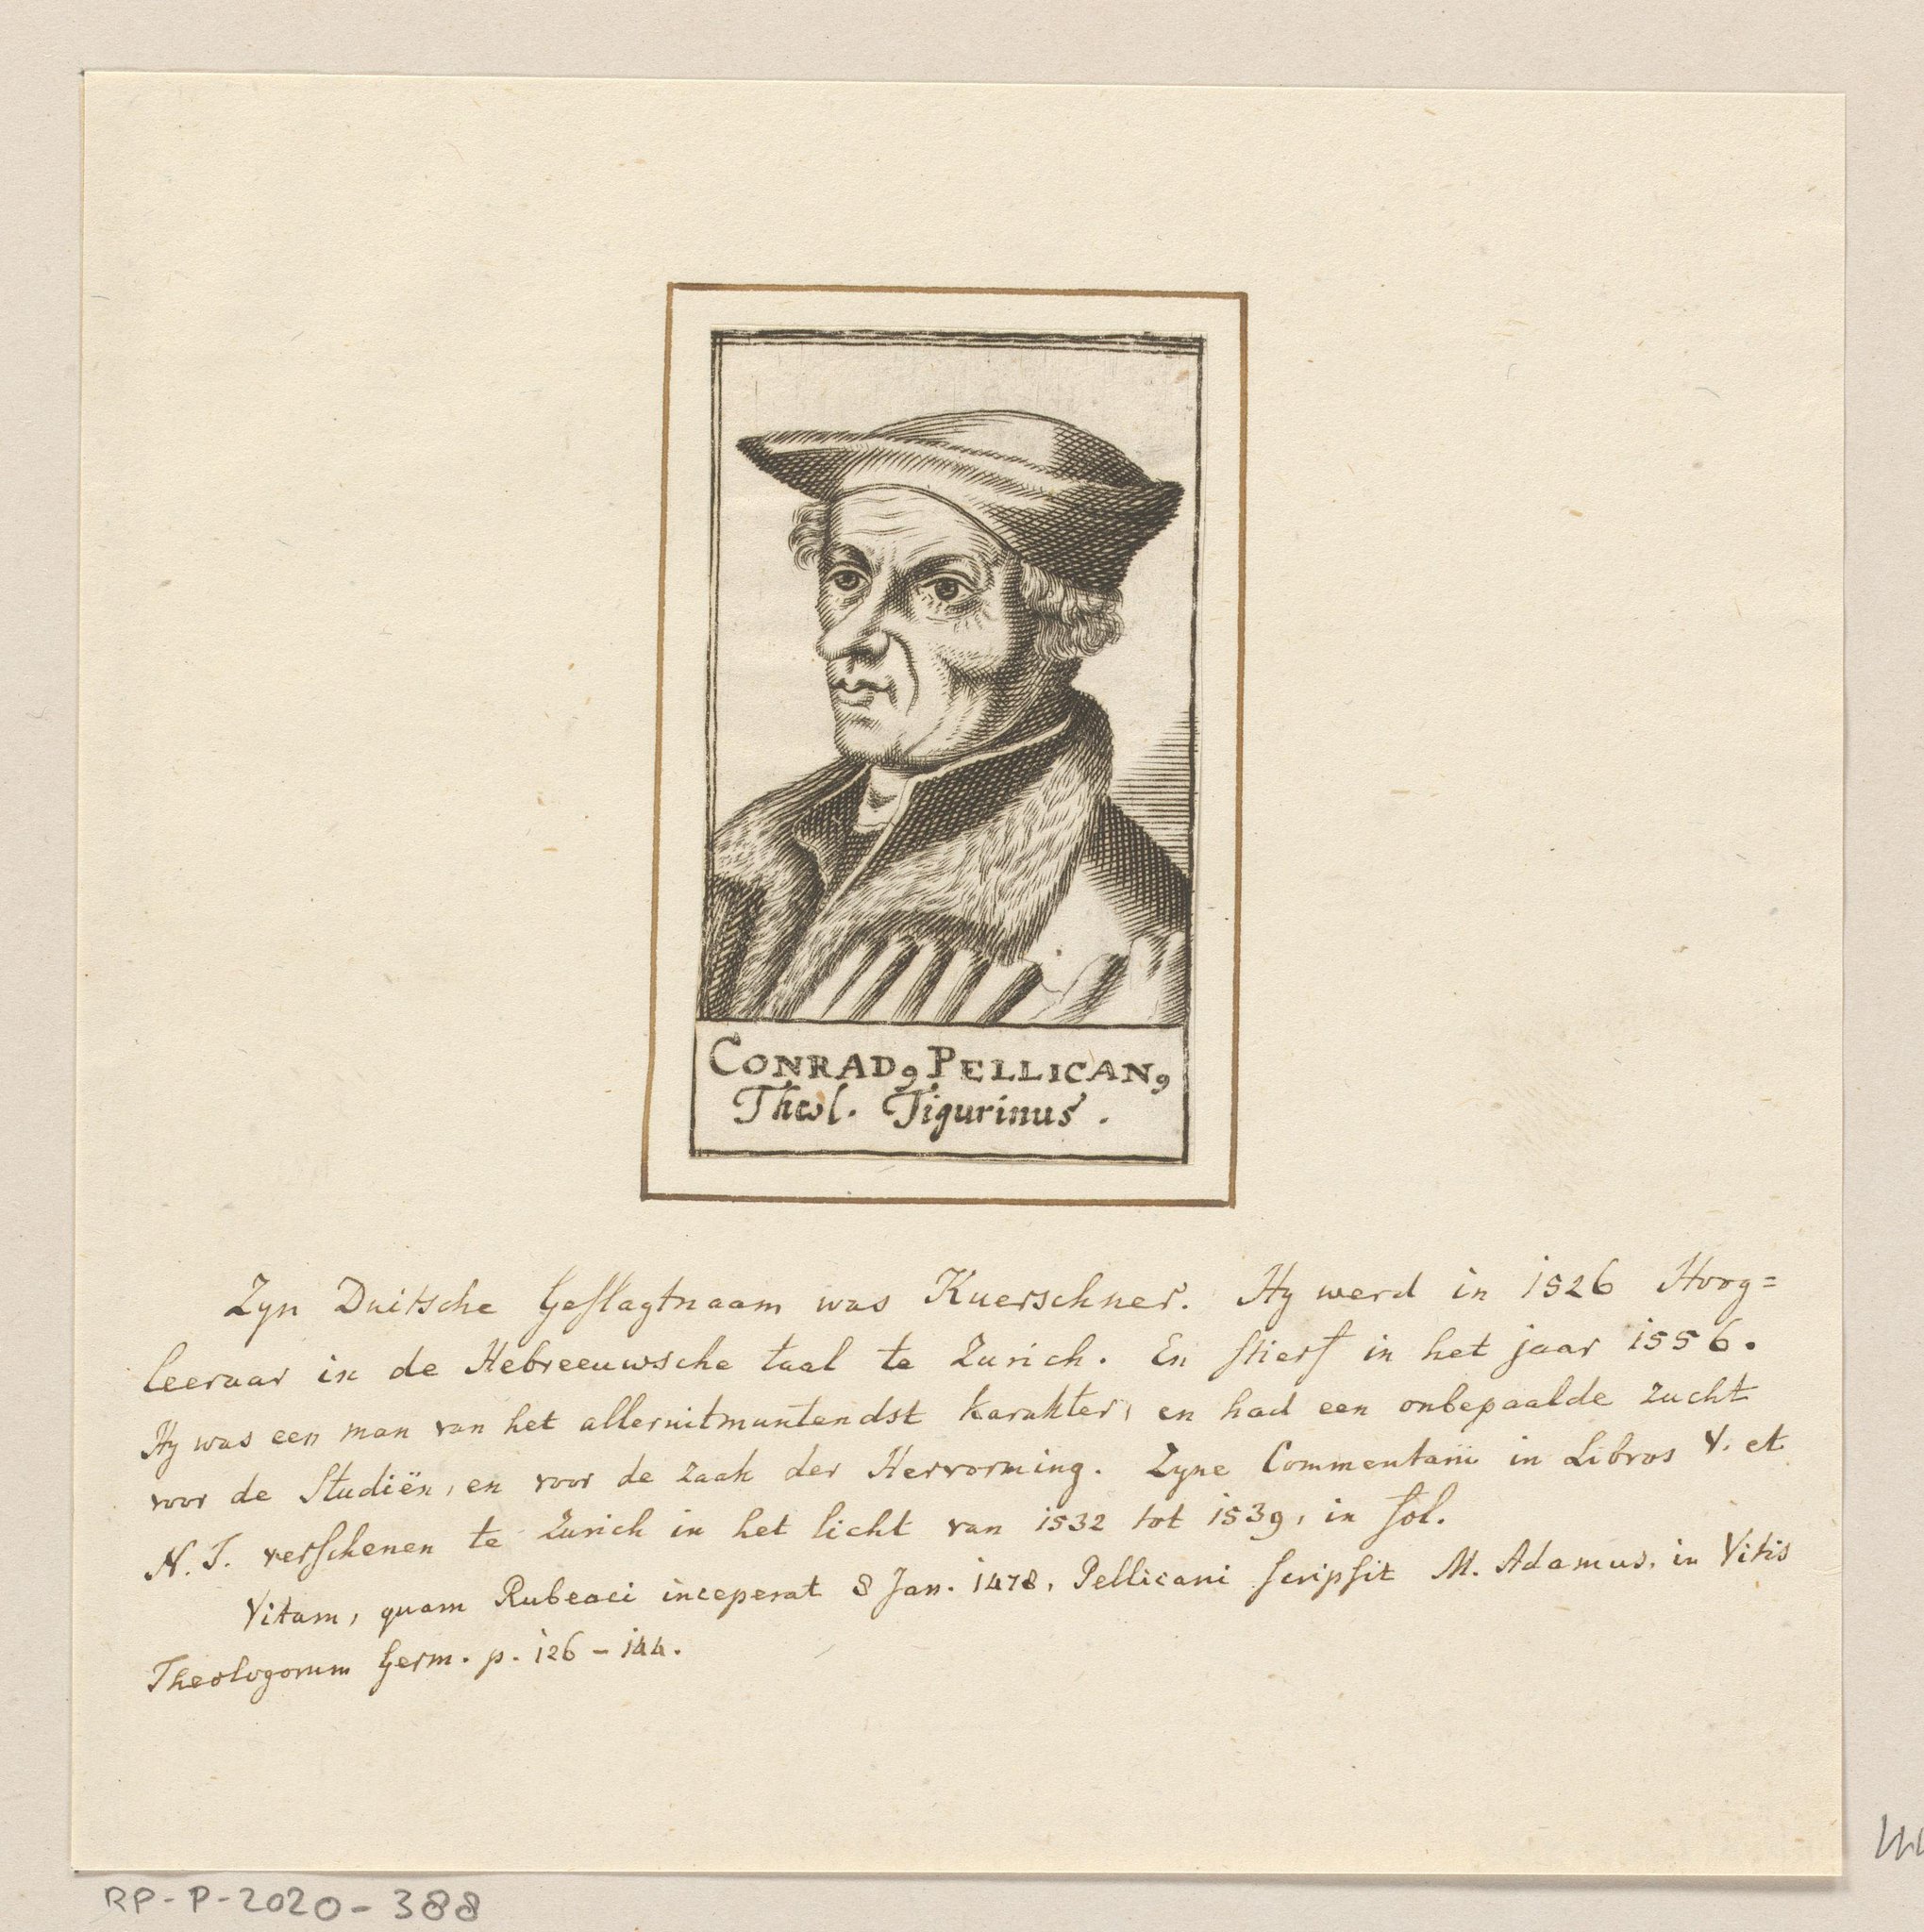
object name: book illustration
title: Conrad[us] Pellican[us] theol. Tigurinus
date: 1688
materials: paper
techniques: engraving, etching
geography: nuremberg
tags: theologian, historical persons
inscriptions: inscription: ‘Zijn Duitsche geslagtnaam was Kuerschner (...)’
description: Prent uit: Freher, Paul. Theatrum virorum eruditione clarorum. Neurenberg: Johann Hoffmann, 1688.